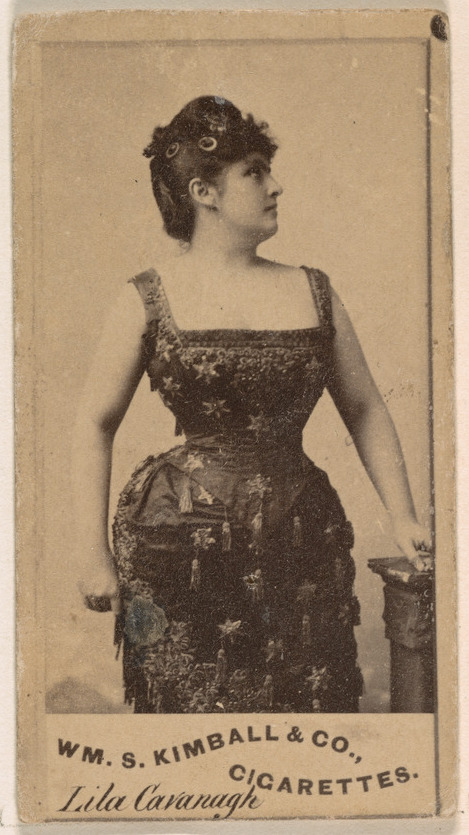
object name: photograph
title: Lila Cavanaugh, from the Actresses series (N203) issued by Wm. S. Kimball & Co.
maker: william s. kimball & company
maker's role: publisher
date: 1889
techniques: color lithograph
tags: portraits,women,actresses